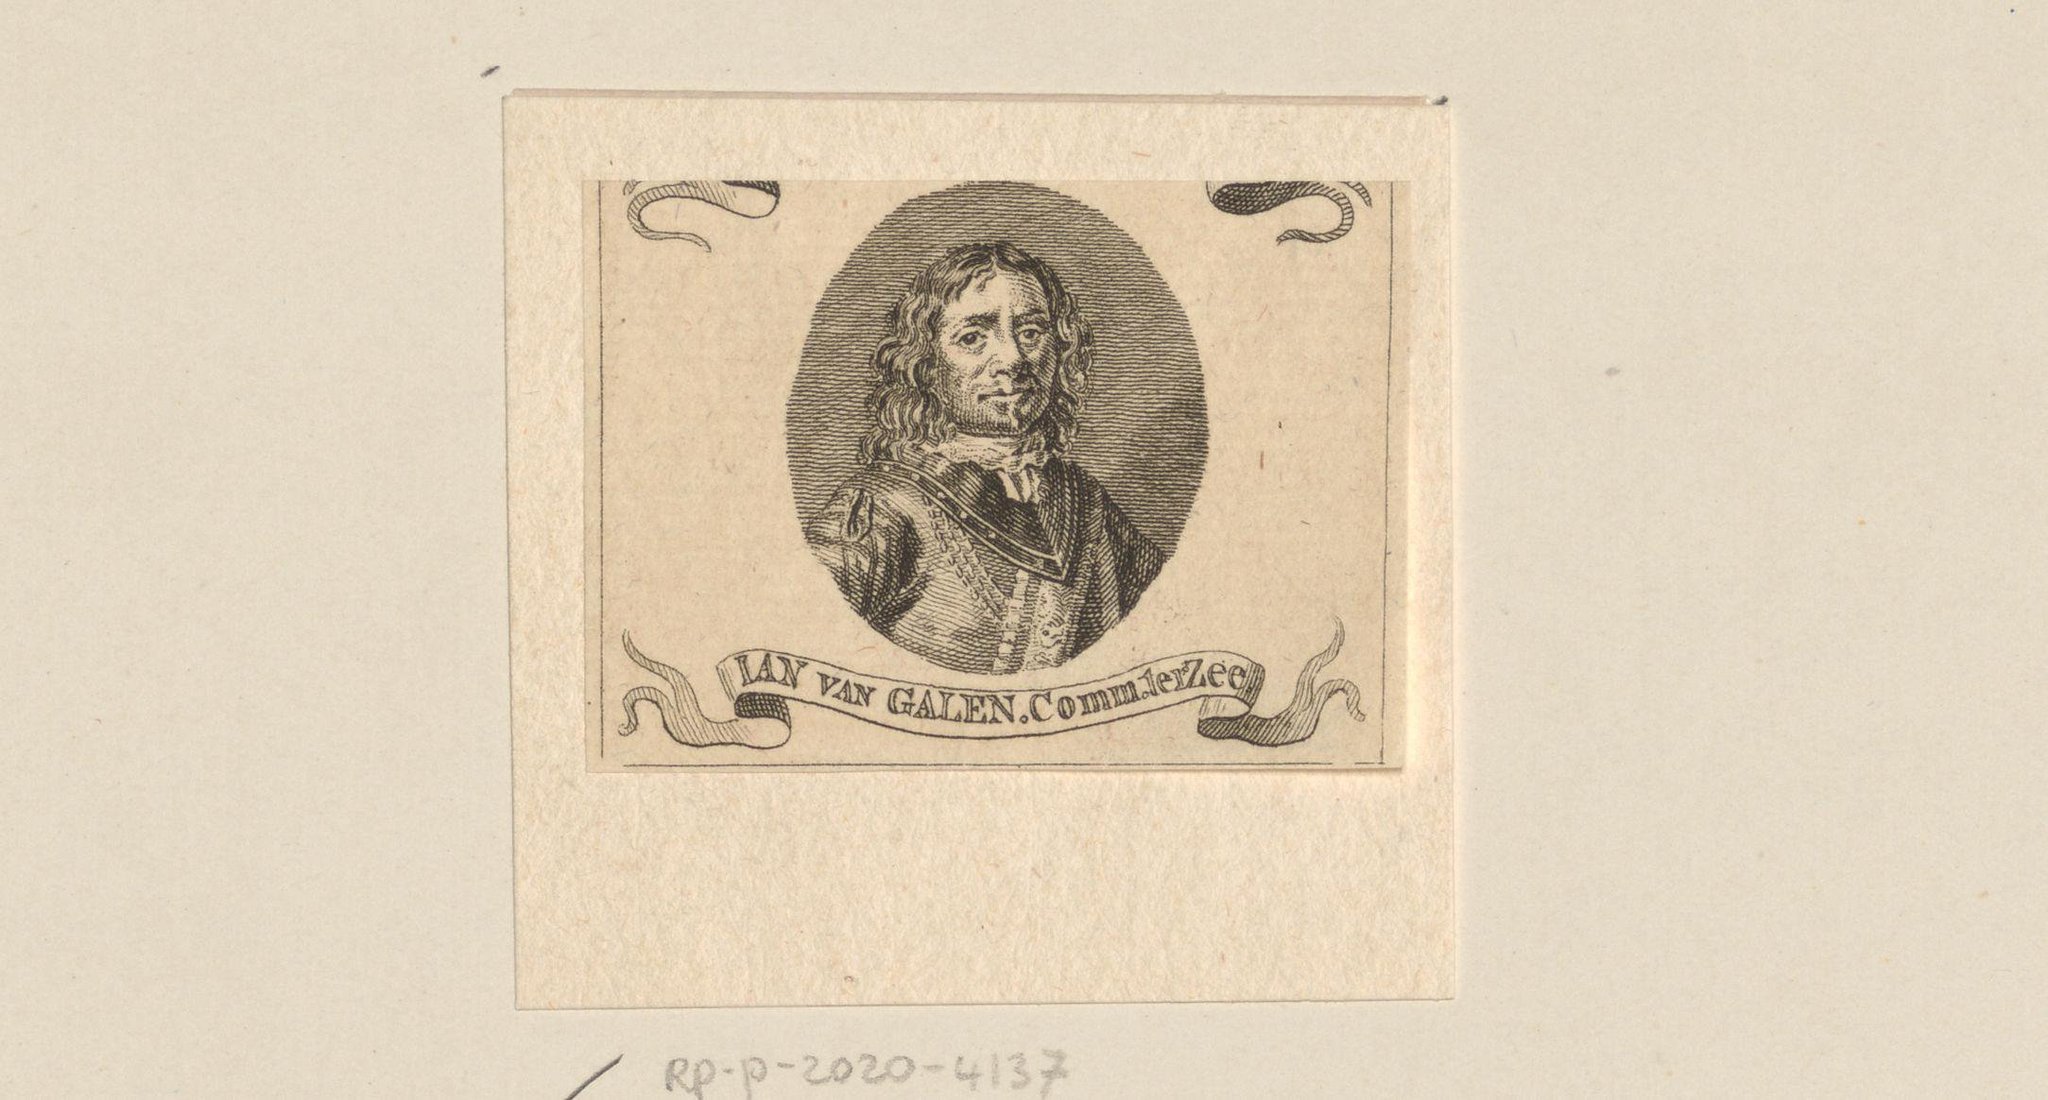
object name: print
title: Ian van Galen, Comm ter Zee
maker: Anonymous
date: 1655-1760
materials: paper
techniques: etching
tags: essen, commander-in-chief, general, marshal, historical persons